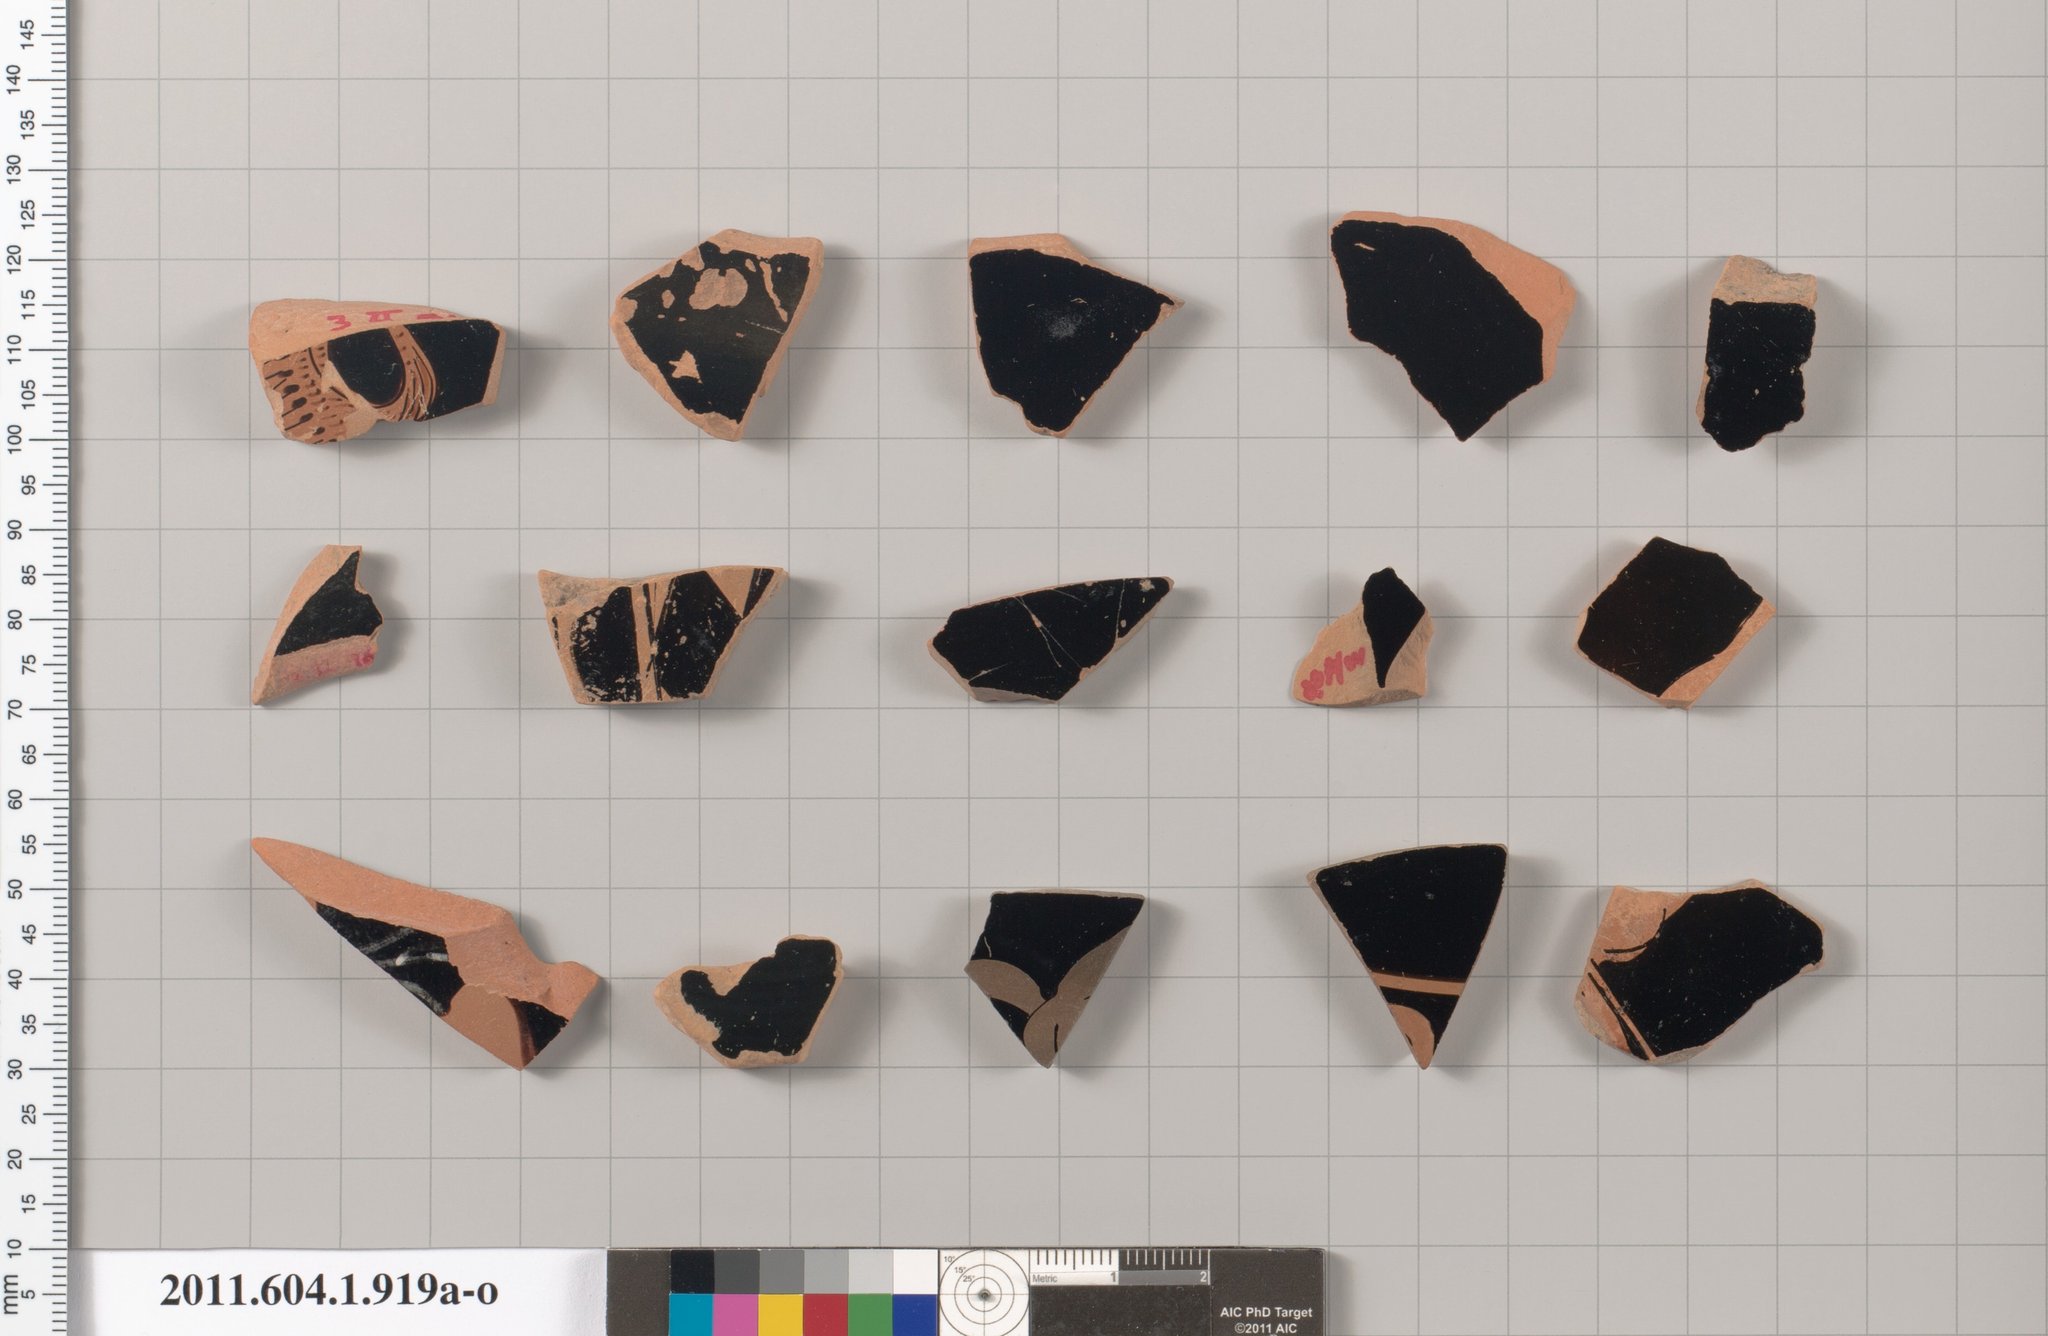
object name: kylix fragment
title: Terracotta fragments of kylikes (drinking cups)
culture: greek, attic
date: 500-401 BCE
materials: terracotta